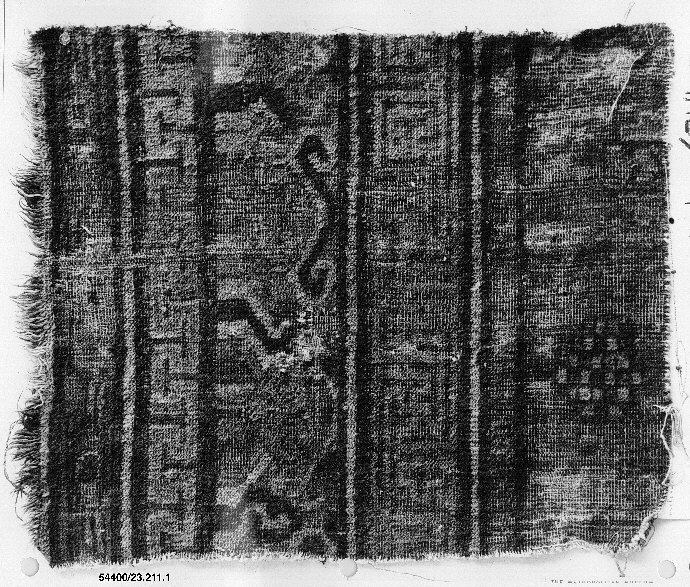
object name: carpet fragment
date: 1601-1700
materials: cotton, wool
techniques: asymmetrically knotted pile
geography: uzbekistan